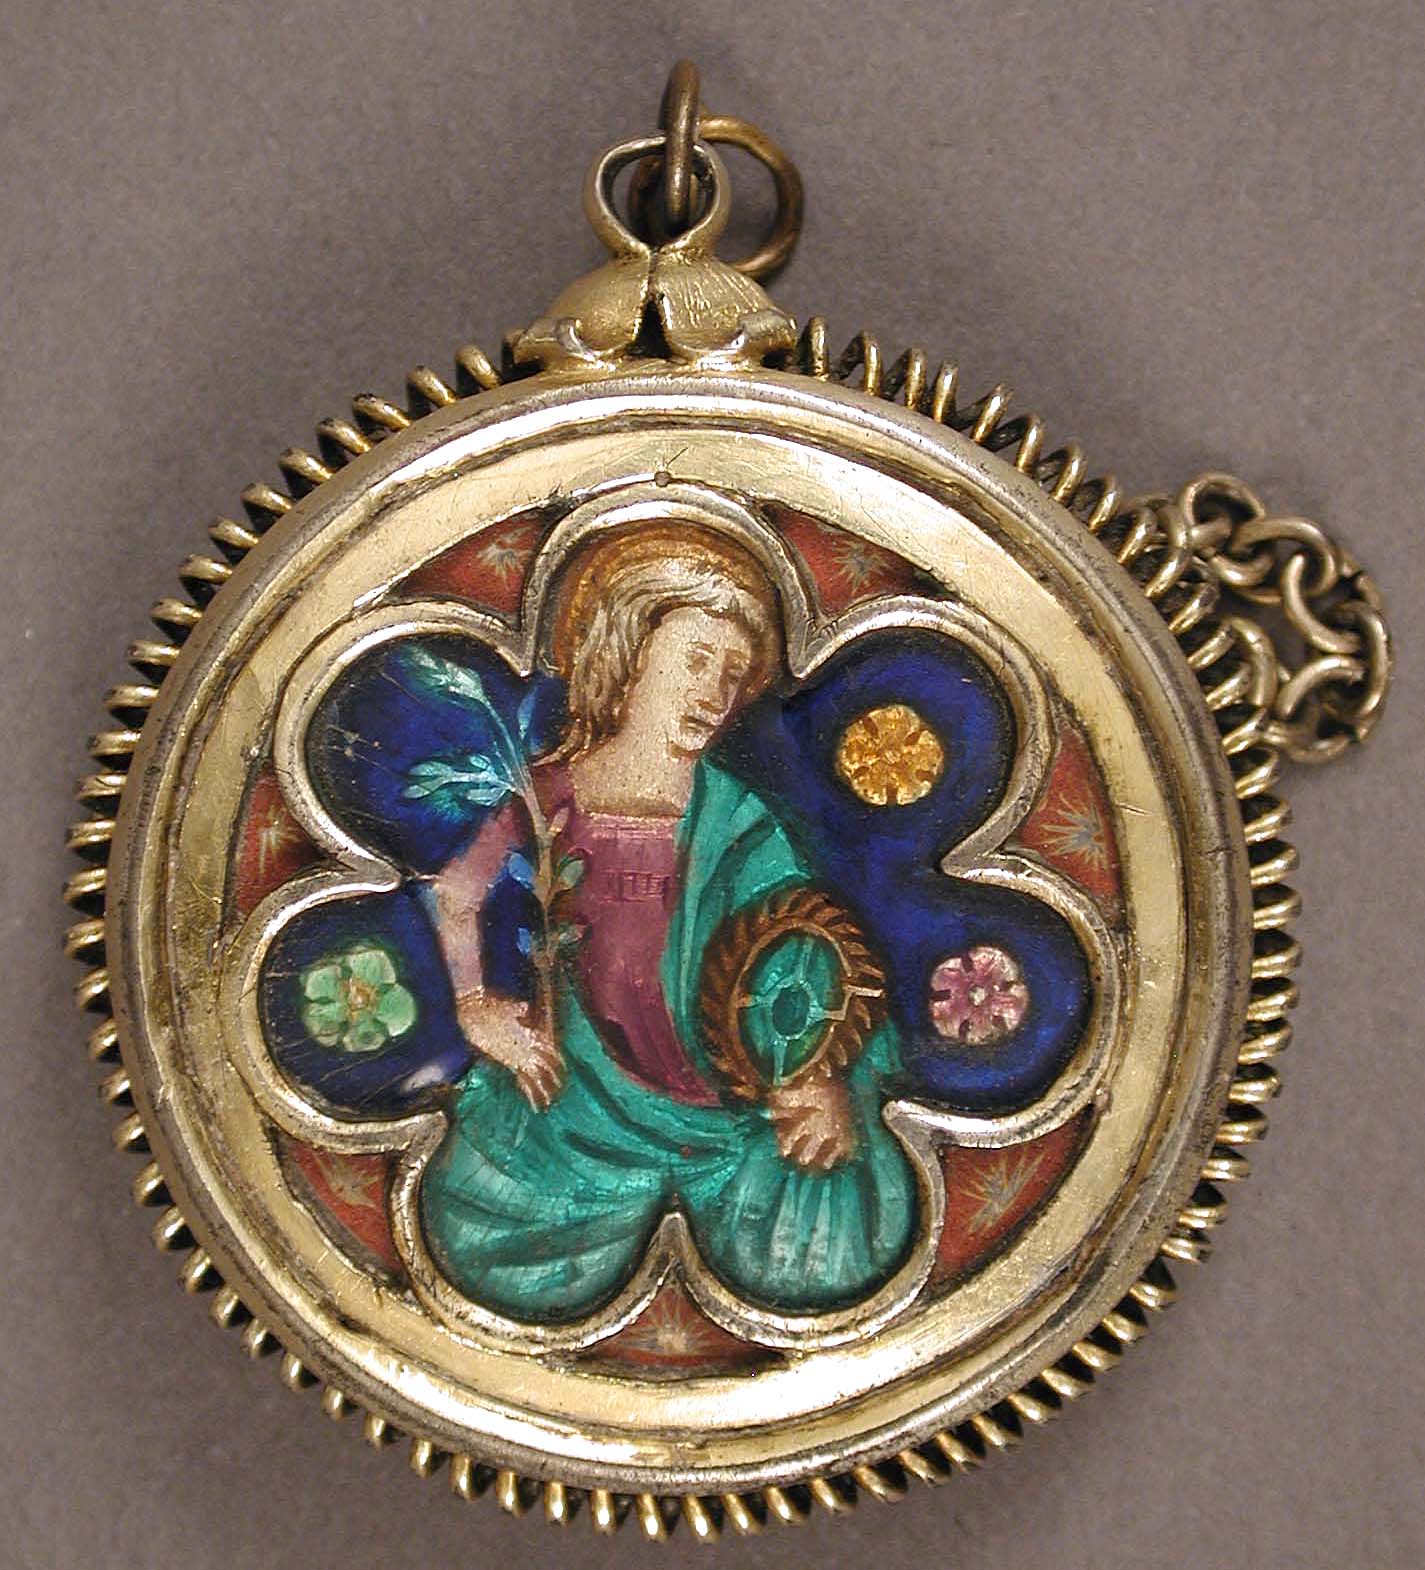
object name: locket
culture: french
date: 1301-1400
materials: enamel, silver gilt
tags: human figures,lambs